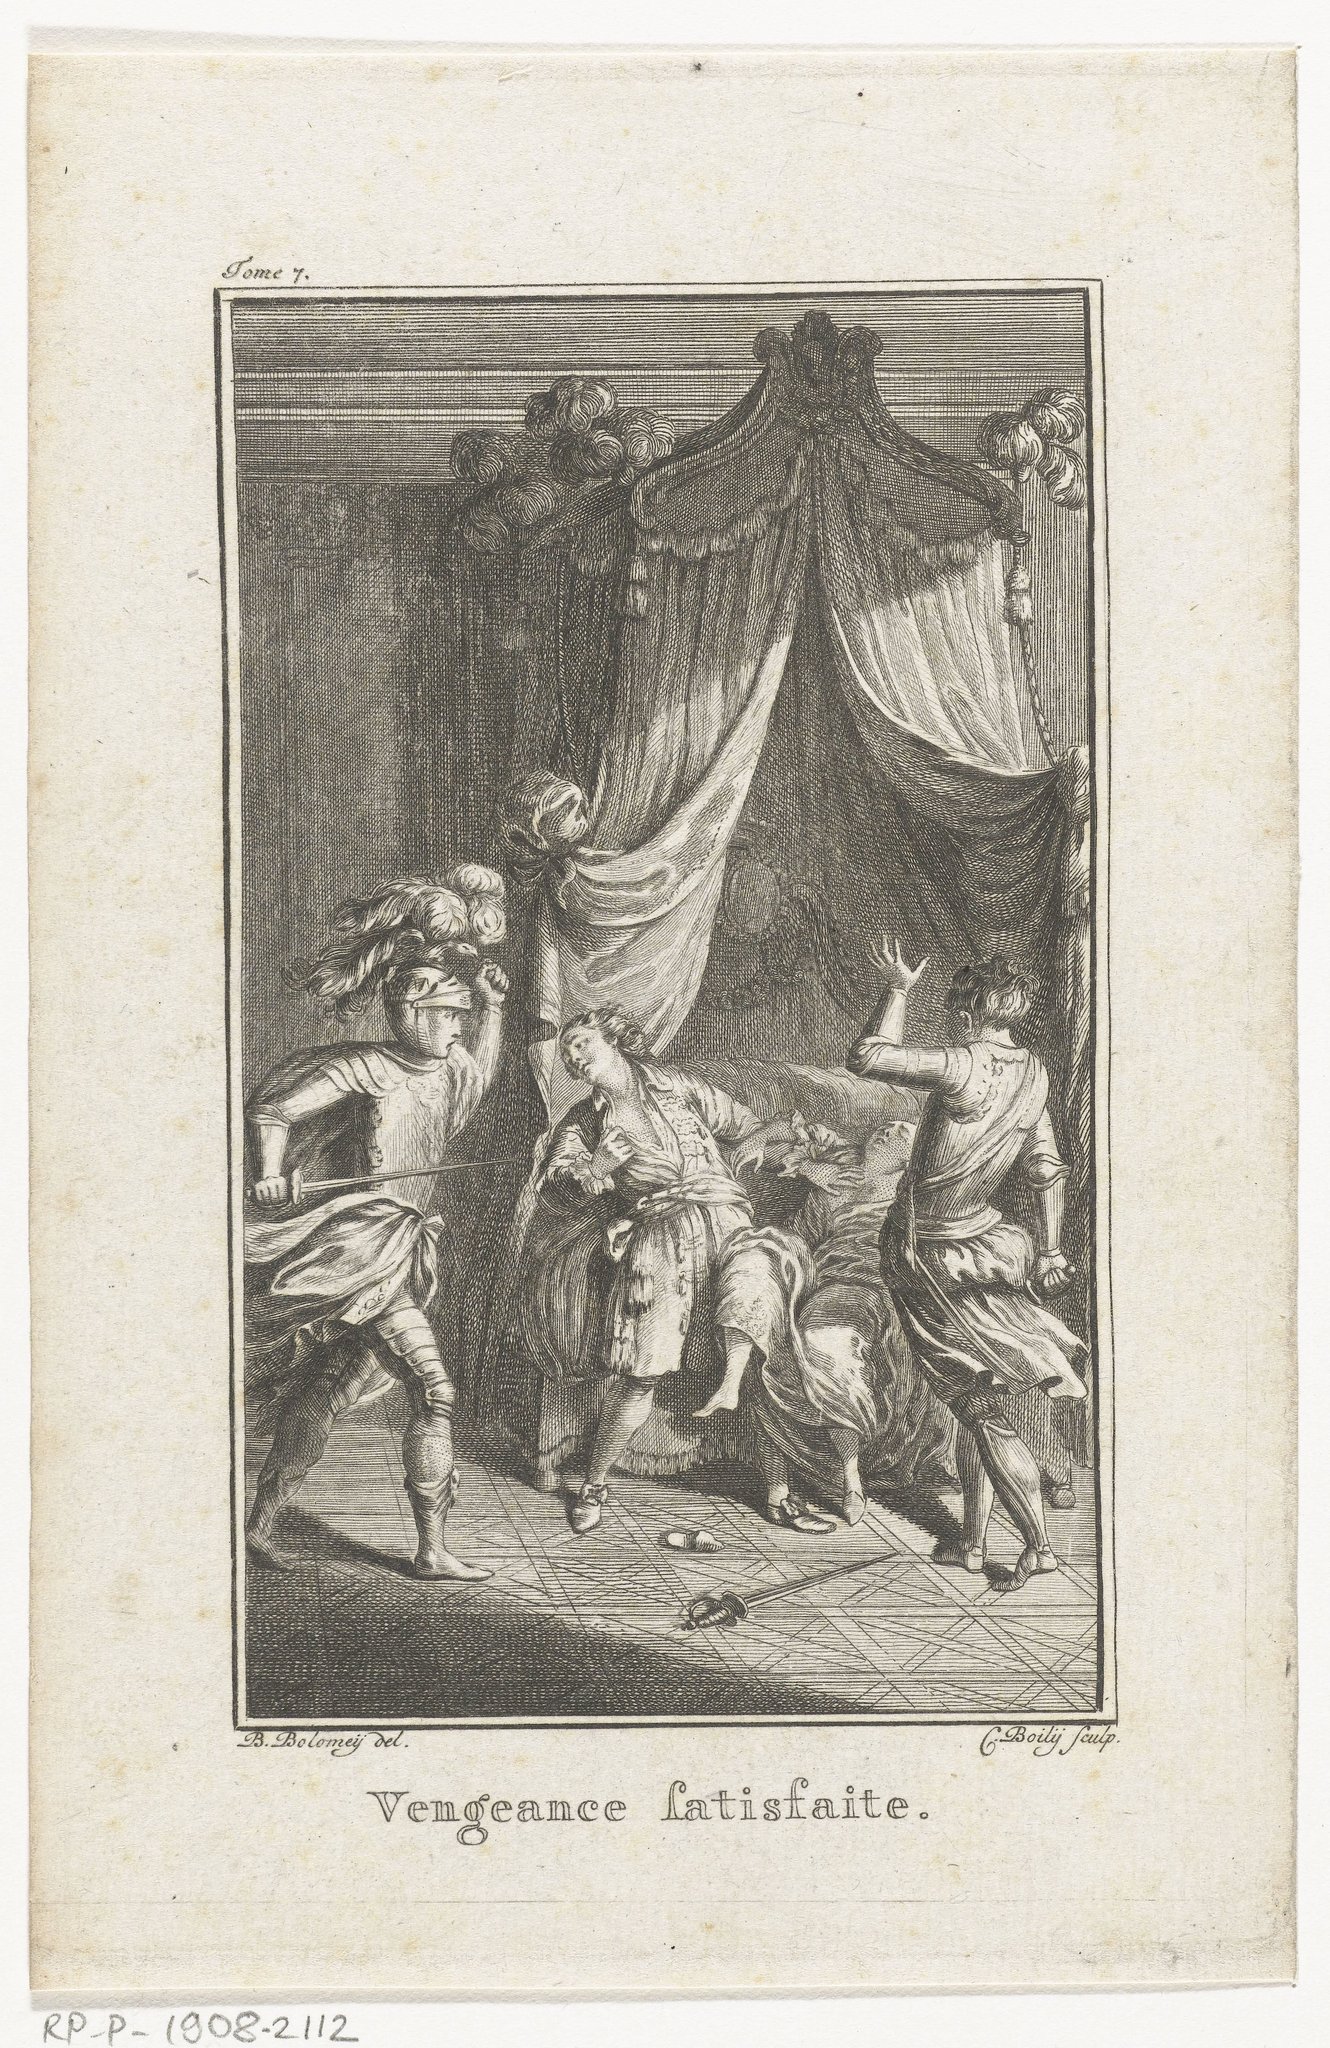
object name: print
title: Betrapt overspel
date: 1753-1813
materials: paper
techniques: etching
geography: netherlands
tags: adultery revenged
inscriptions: collector's mark: Lugt 2228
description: Een liefdespaar wordt verast door de echtgenoot van de vrouw. Deze bedreigt de twee met een sabel. Titelillustratie voor deel 7 van een boek over de perikelen van de liefde.